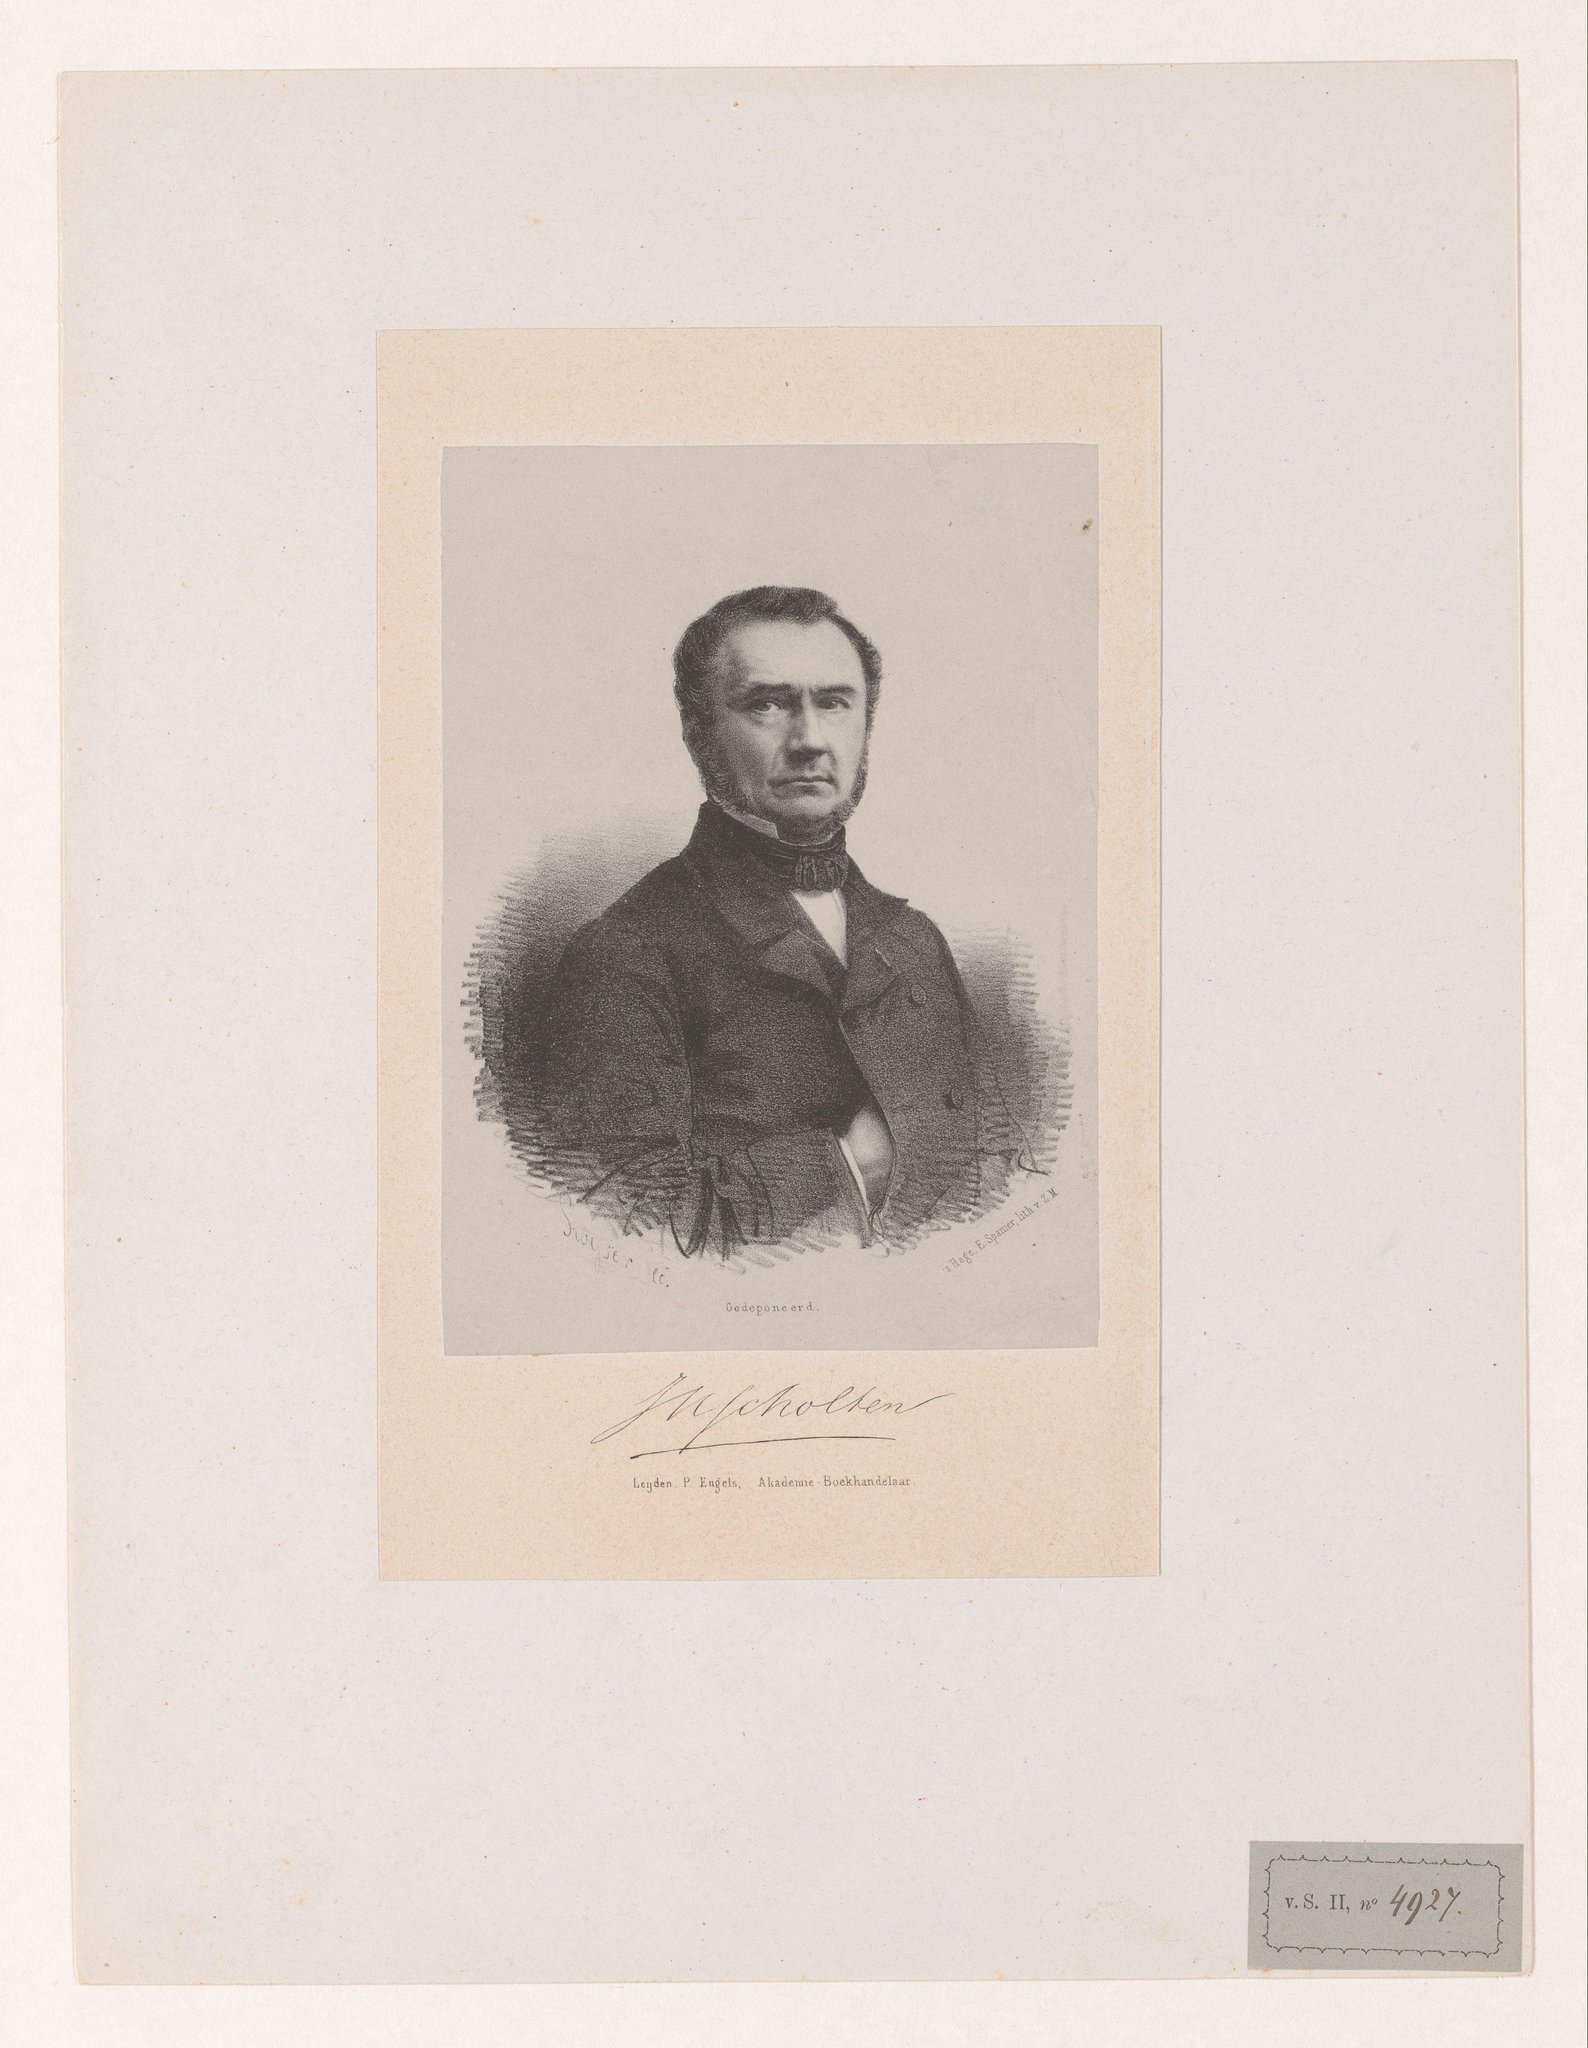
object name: print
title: Portret van Johannes Henricus Scholten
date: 1849-1863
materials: paper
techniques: lithograph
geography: leiden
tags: leiden, historical persons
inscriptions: collector's mark: Lugt 2228, : ‘Gedeponeerd.’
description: Onder het portret de signatuur van de geportretteerde.